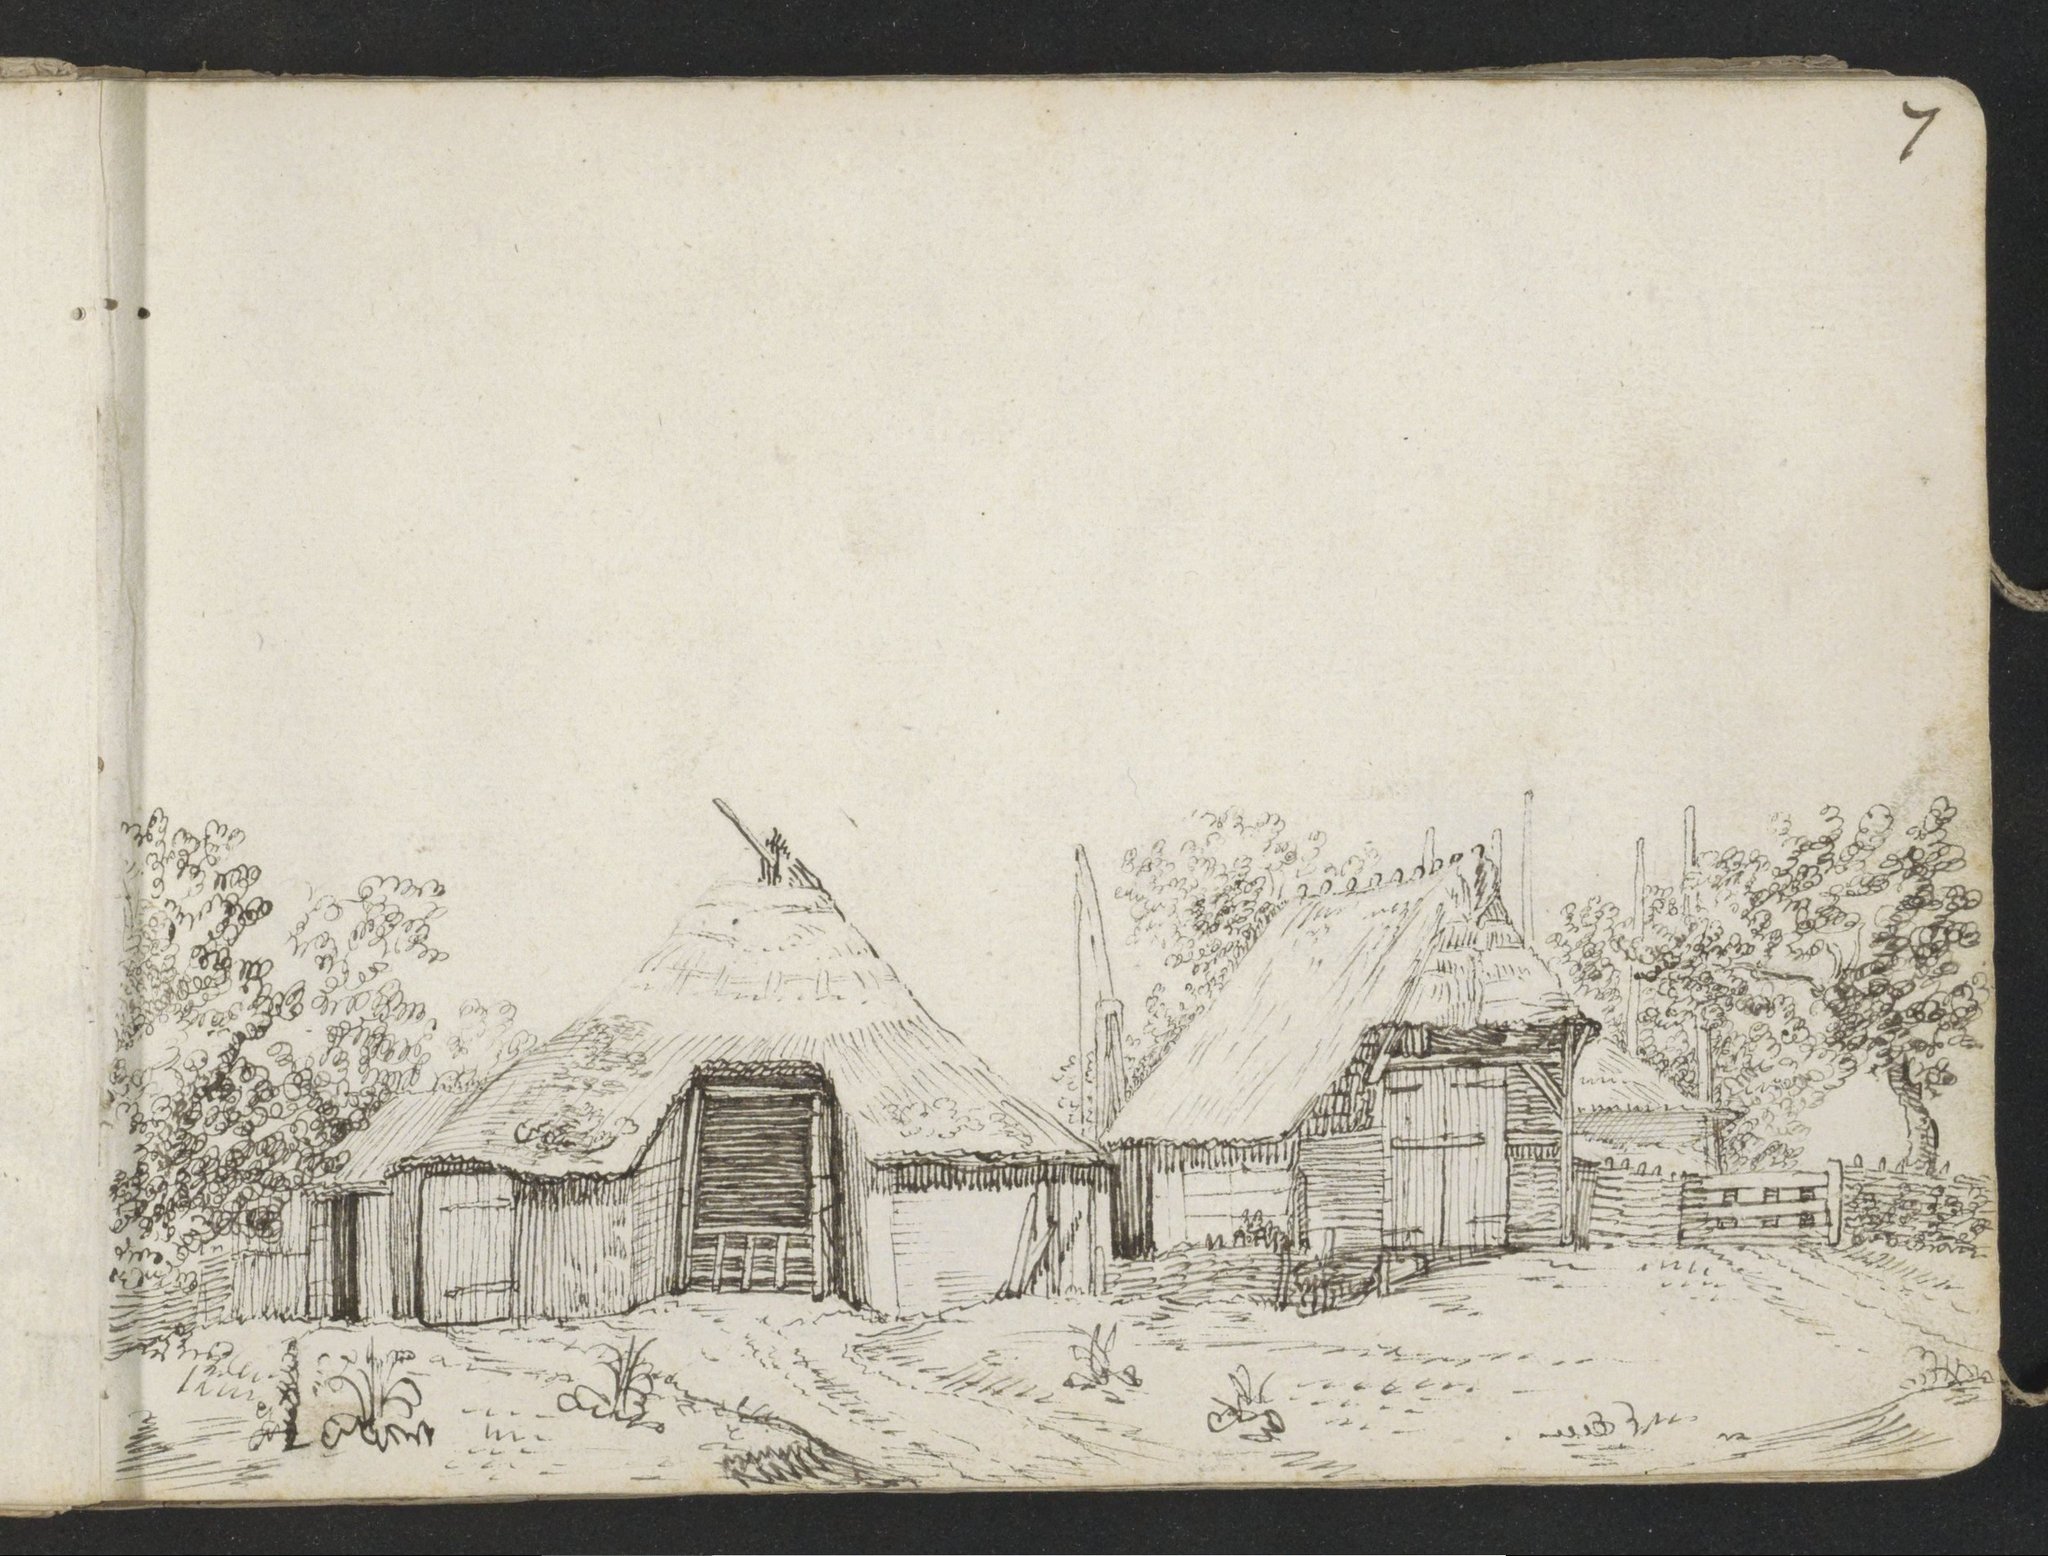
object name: sketchbook leaf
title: Twee boerderijen buiten Zwolle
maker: gerard ter borch (ii)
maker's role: draughtsman, painter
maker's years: 1617-1681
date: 1631-1633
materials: ink, paper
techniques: pen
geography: zwolle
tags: farm (building)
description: Blad 7 recto uit een schetsboek met 55 bladen.